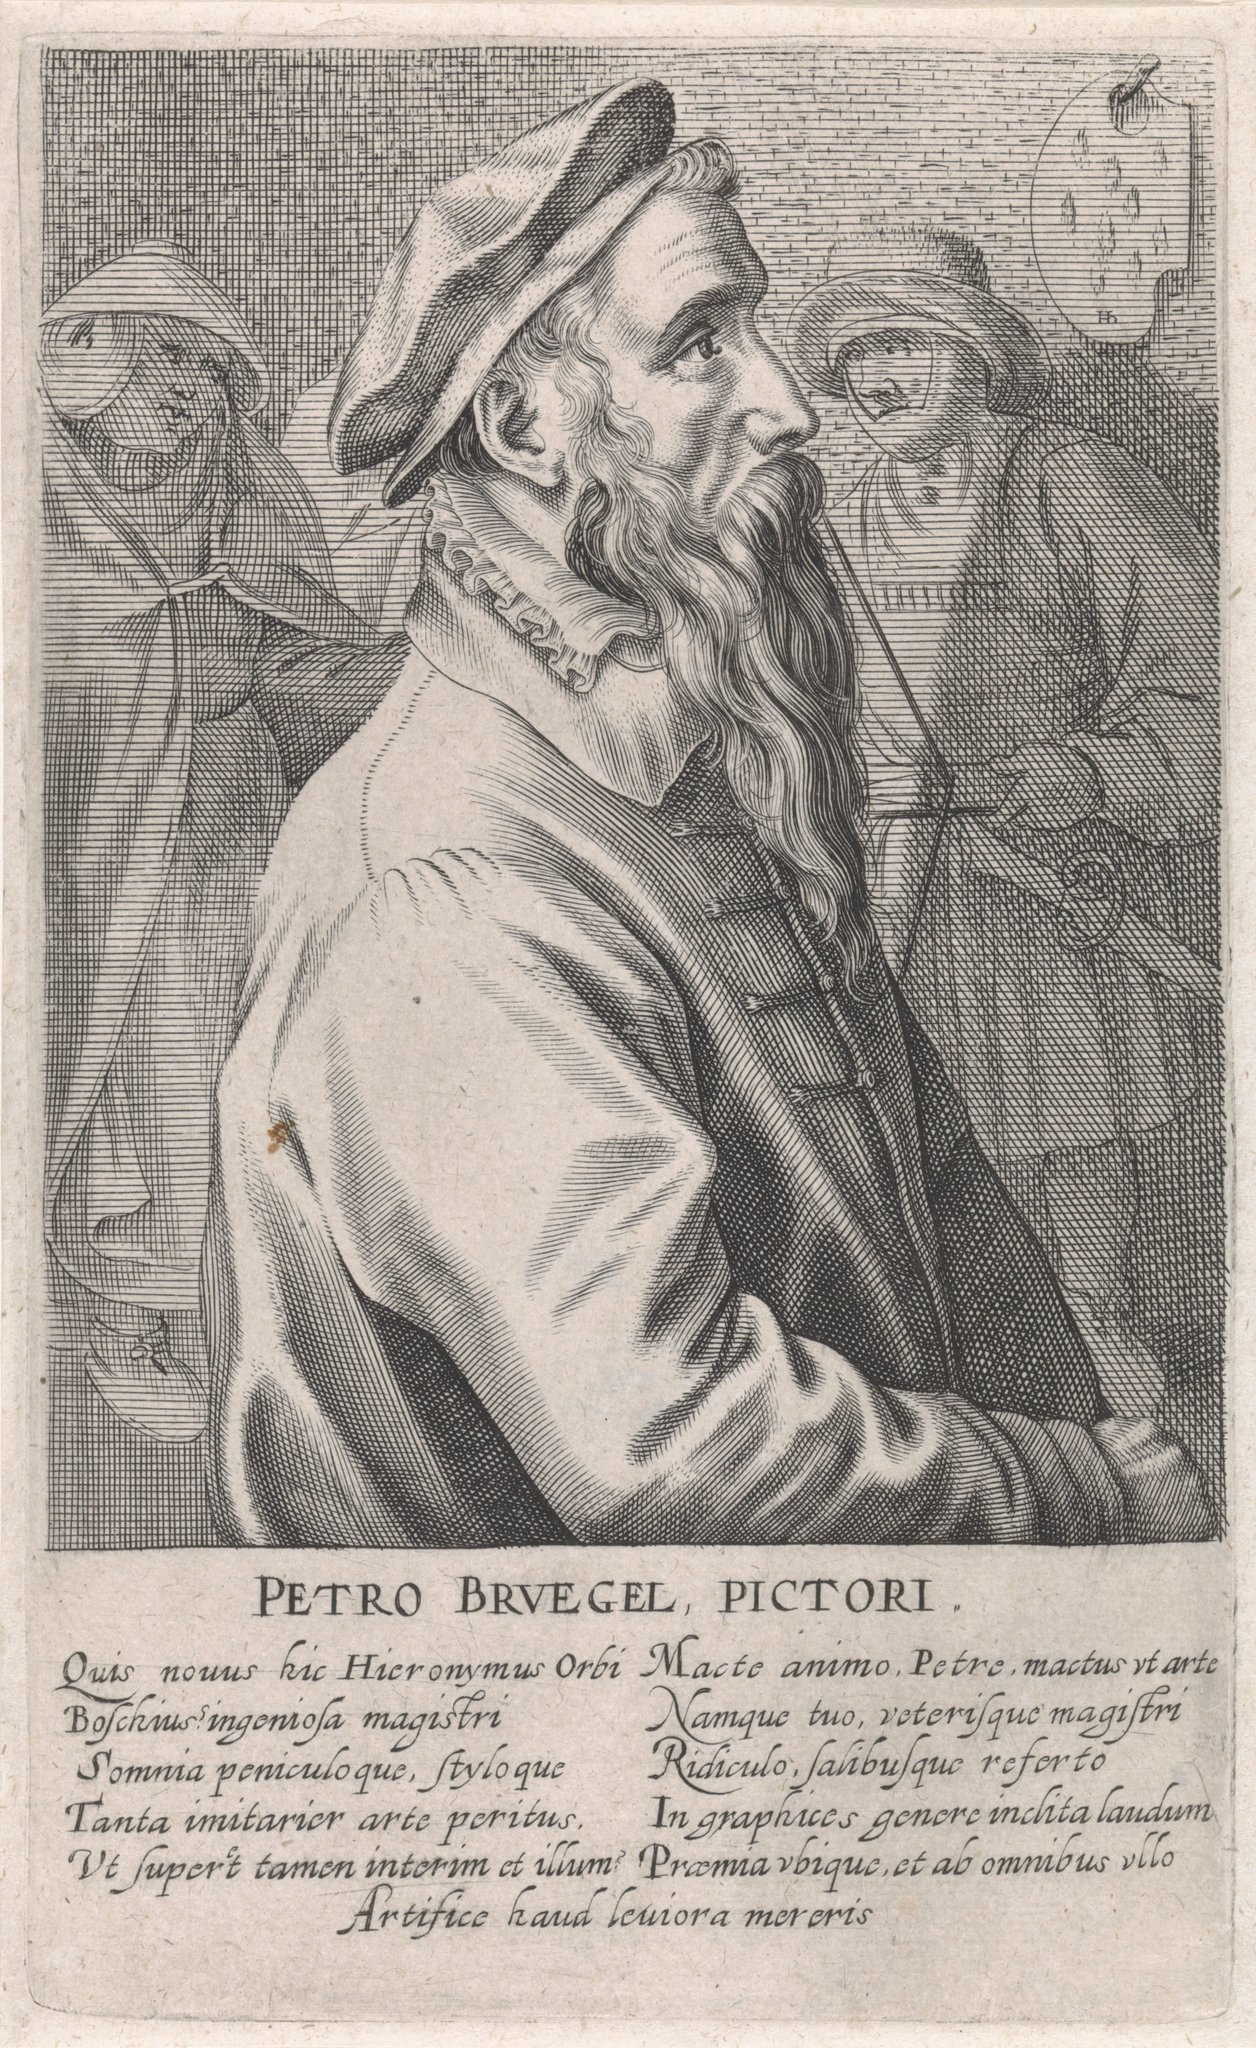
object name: print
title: Pictorum aliquot celebrium praecipuae Germaniae Inferioris effigies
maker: hendrick hondius (i)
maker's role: draughtsman, print maker, publisher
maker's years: 1573-1650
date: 1610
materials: paper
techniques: engraving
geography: the hague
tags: pieter brueghel, portrait, self-portrait of painter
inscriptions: collector's mark: Lugt 2228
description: Portret ten halven lijve naar rechts van Pieter Bruegel. Onder het portret zijn naam en elf regels in het Latijn. Prent uit deel 1 van de serie Pictorum Aliquot Celebrium Praecipuae Germaniae Inferioris Effigies. Serie van 72 kunstenaarsportretten vervaardigd door Hendrick Hondius I, Simon Frisius, Andries Jacobsz. Stock en Robert de Baudous.